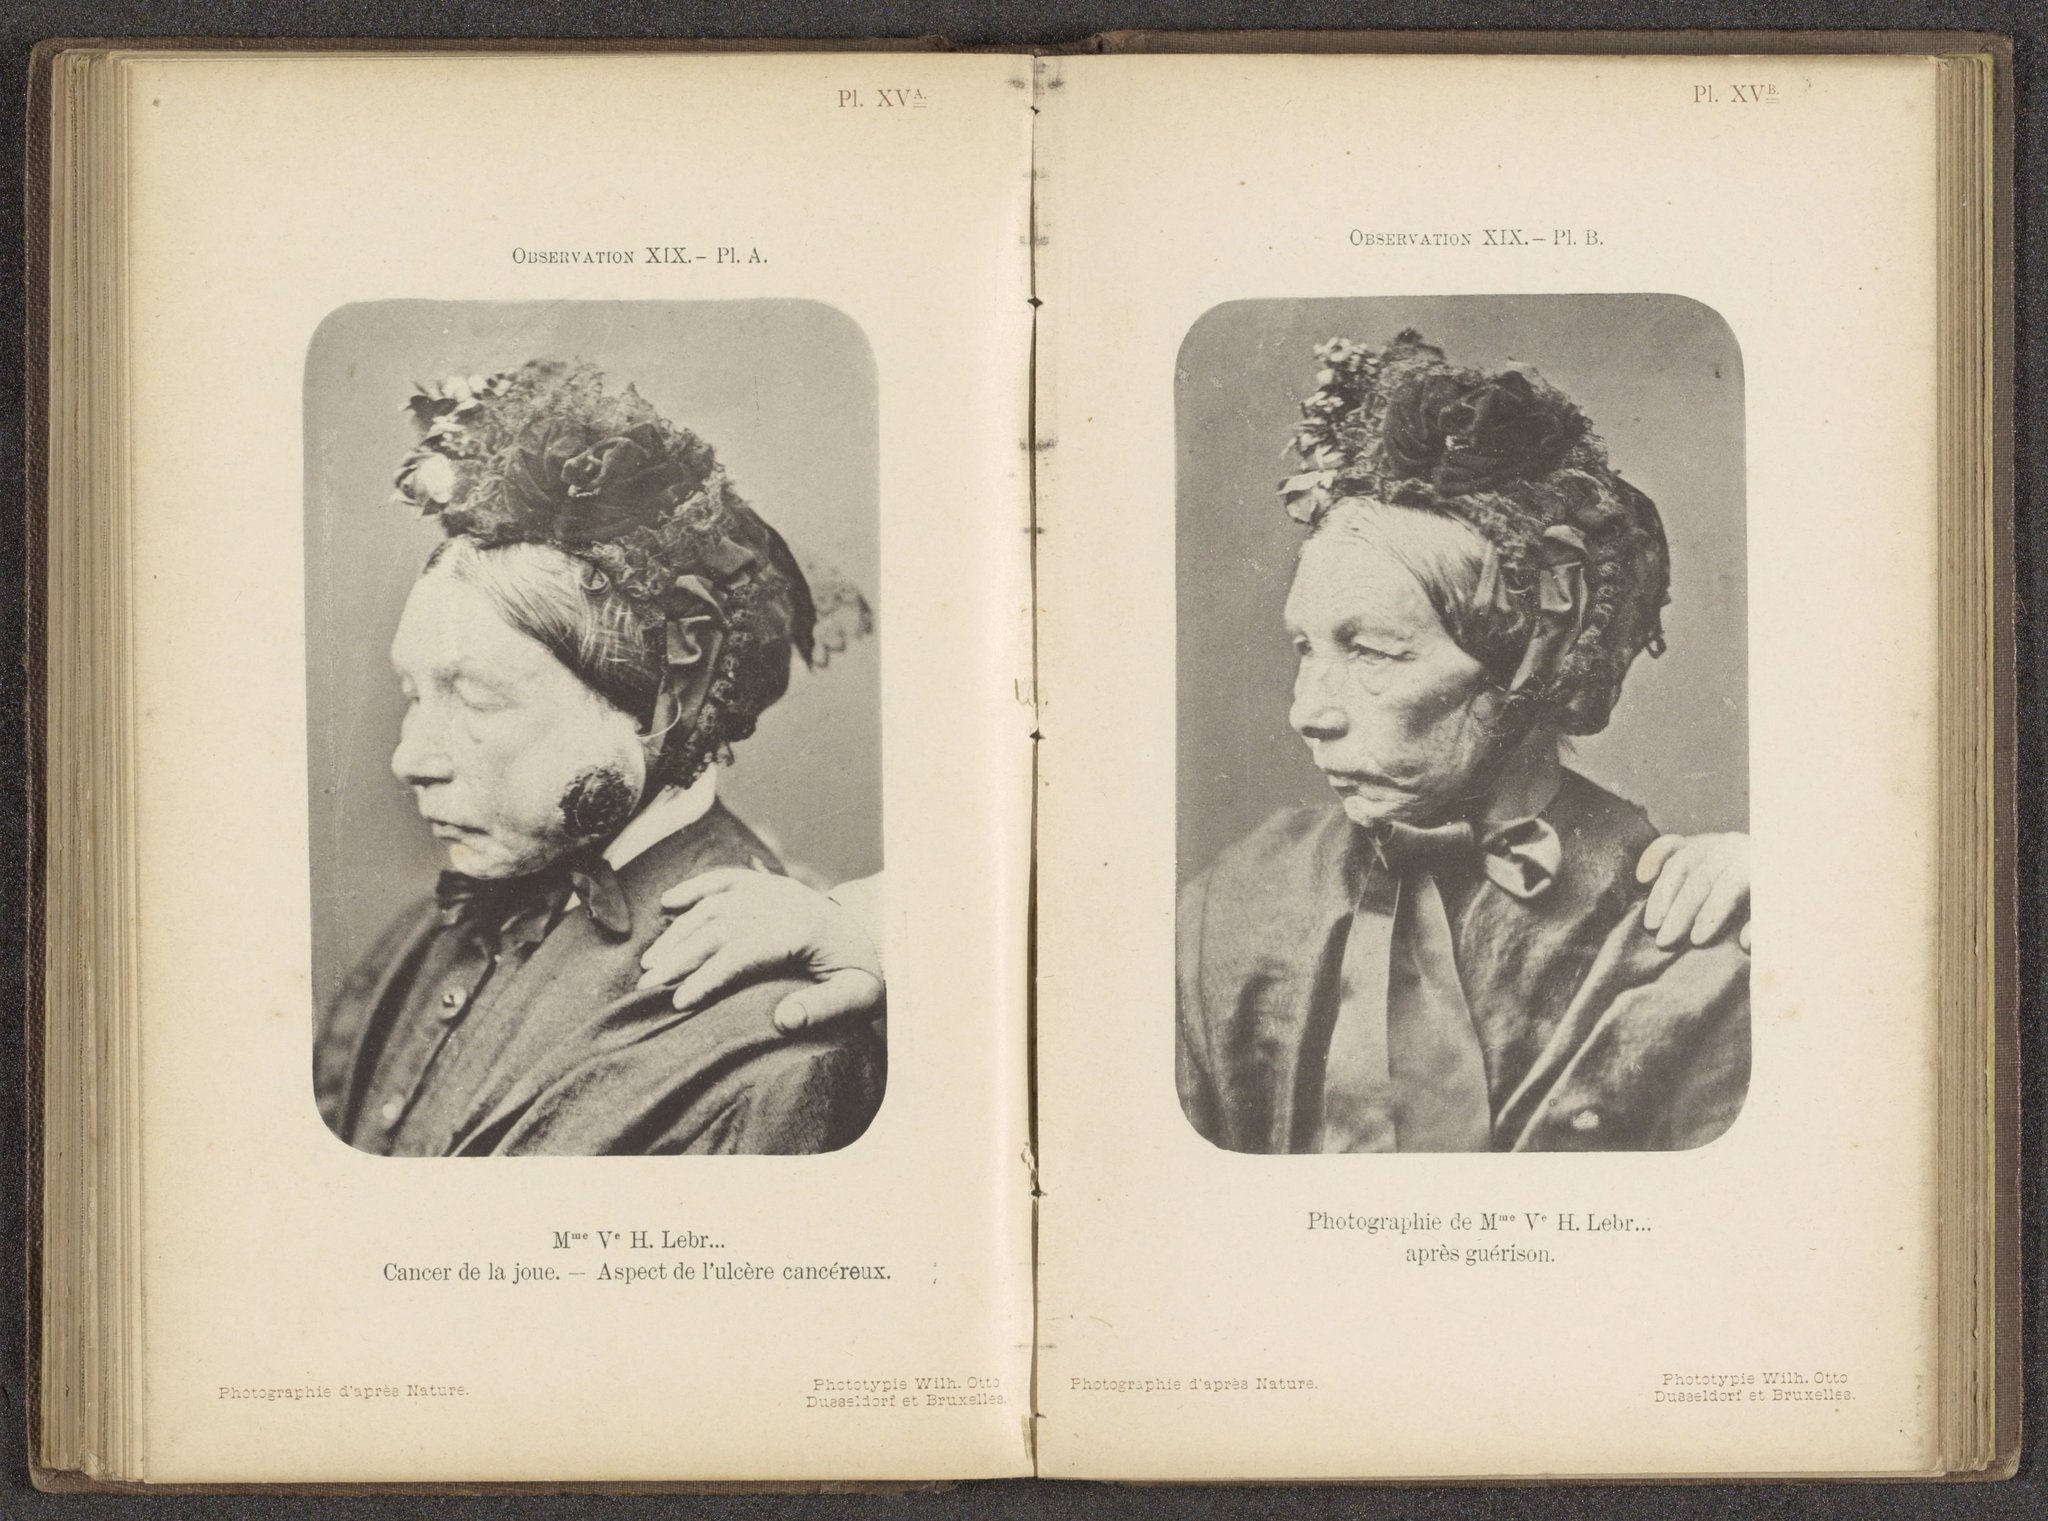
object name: page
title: Vrouw met een litteken op de wang na het verwijderen van een tumor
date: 1874-1884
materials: paper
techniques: photograph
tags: tumours - aa - female human figure, infections and wounds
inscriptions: inscription: ‘Pl. XVB. / Observation XIX. - Pl. B. / Photographie de Mme Ve H. Lebr.... / après guérison.’